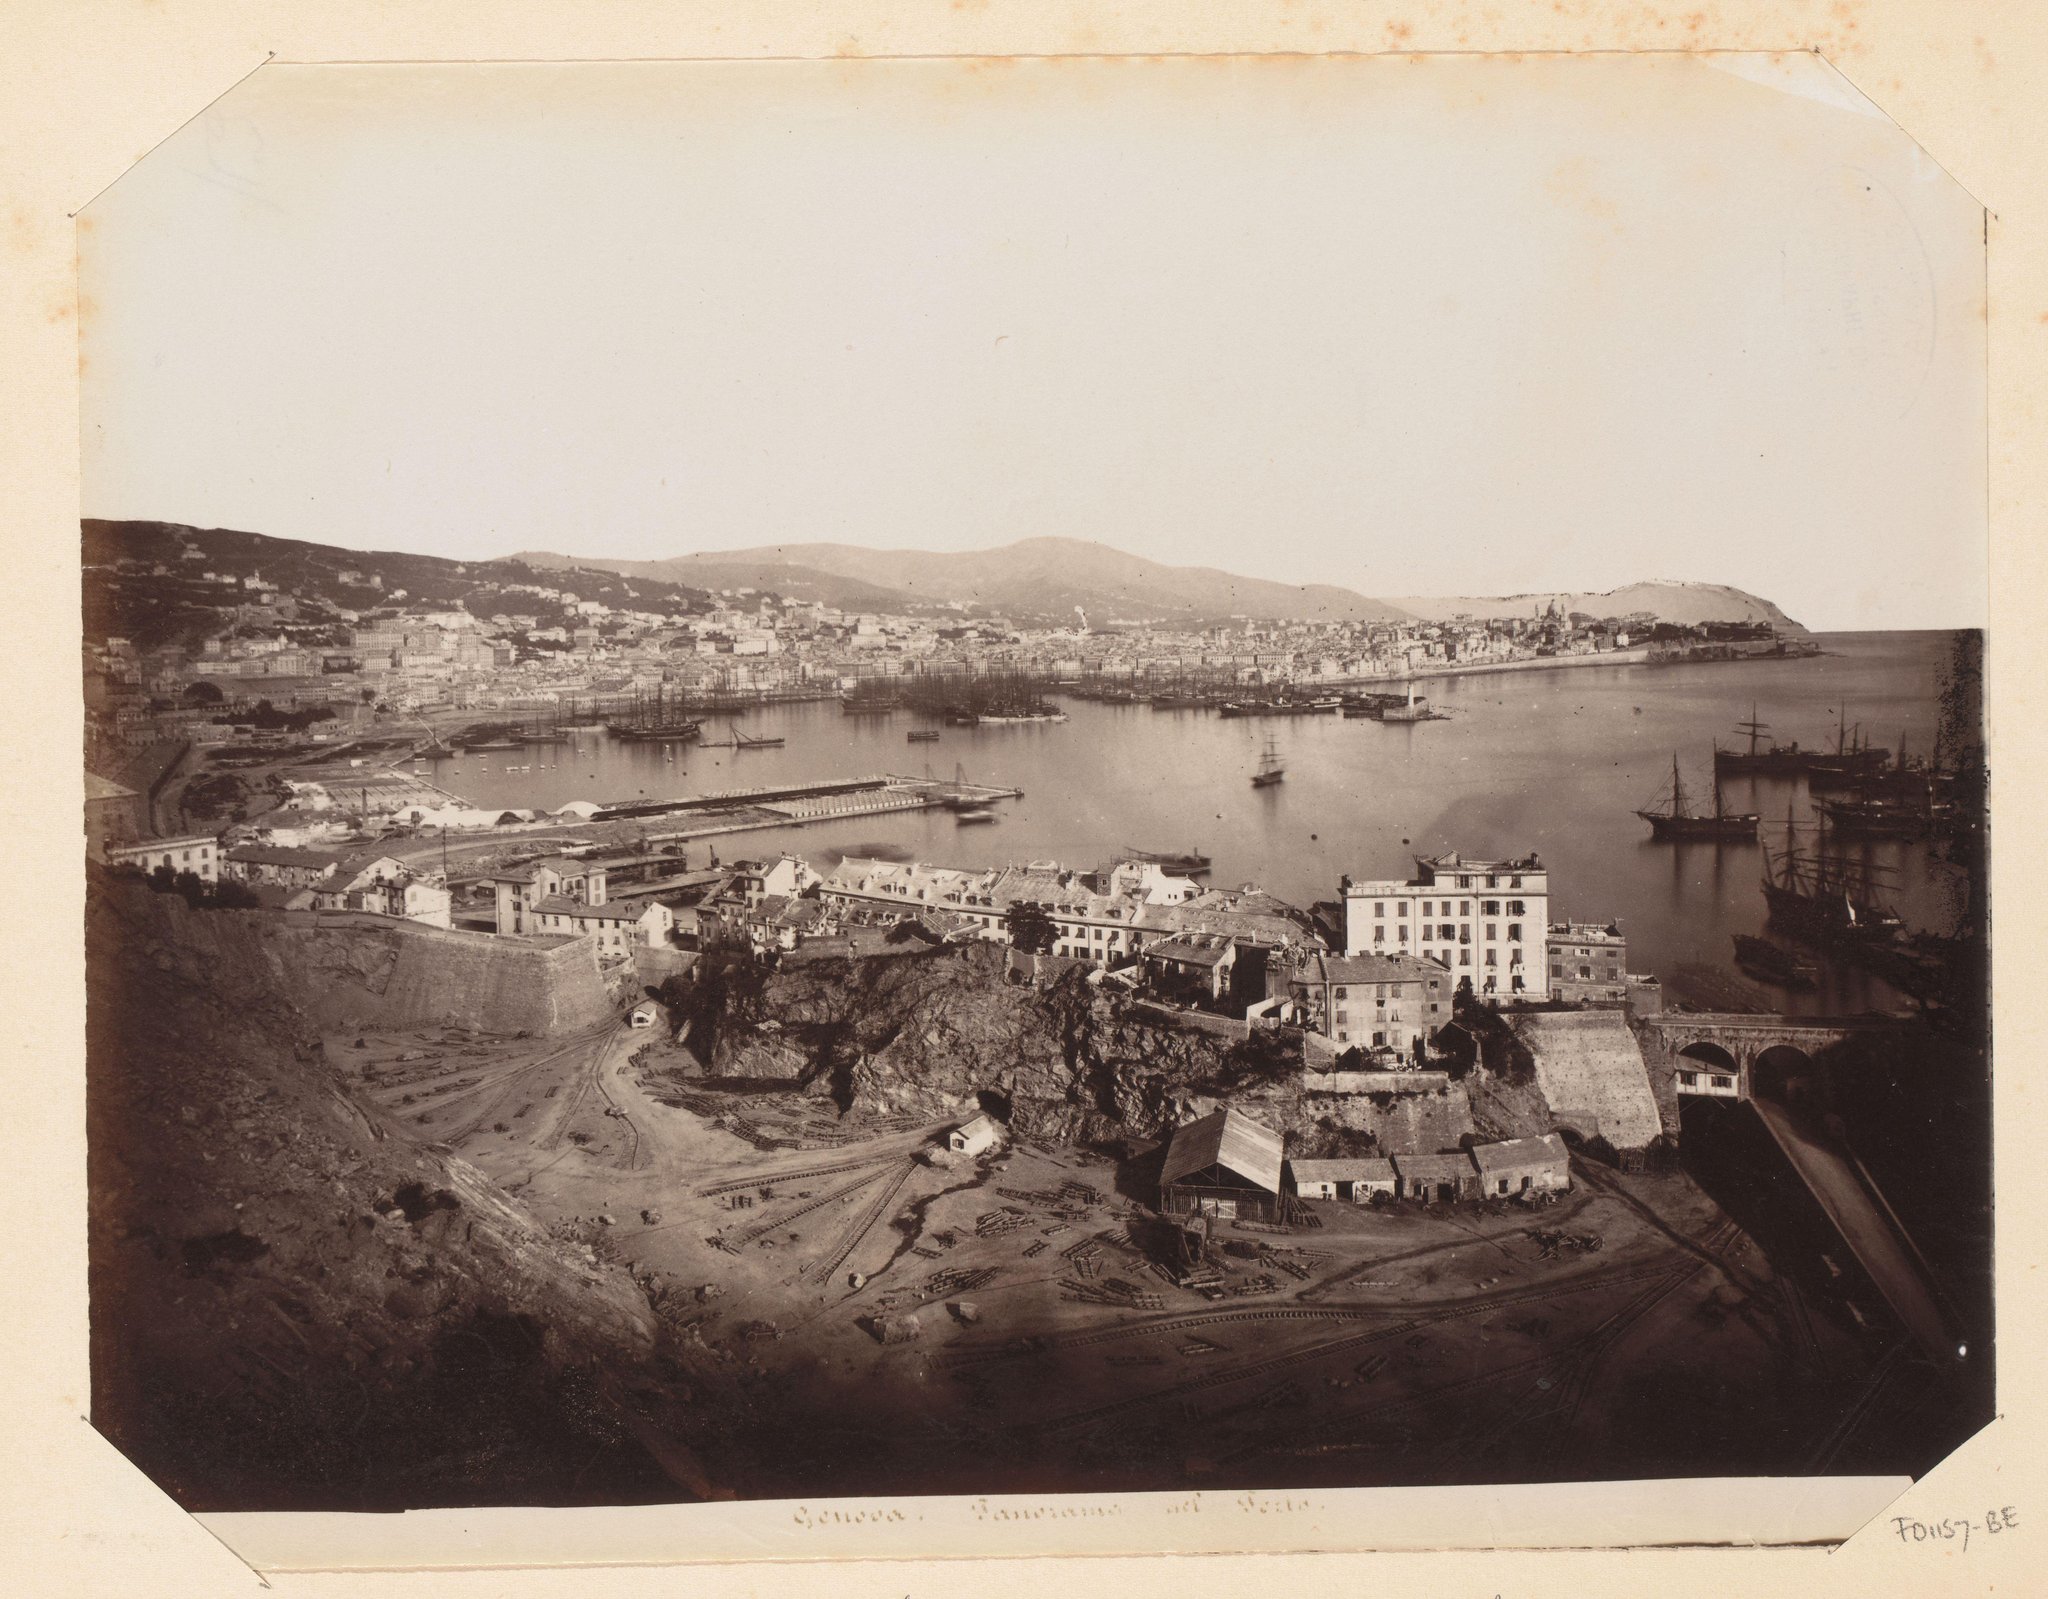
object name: photograph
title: Gezicht op de haven van Genua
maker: Anonymous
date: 1885-1892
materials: photographic support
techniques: albumen print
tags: harbour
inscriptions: annotation: ‘Genua - de Haven’